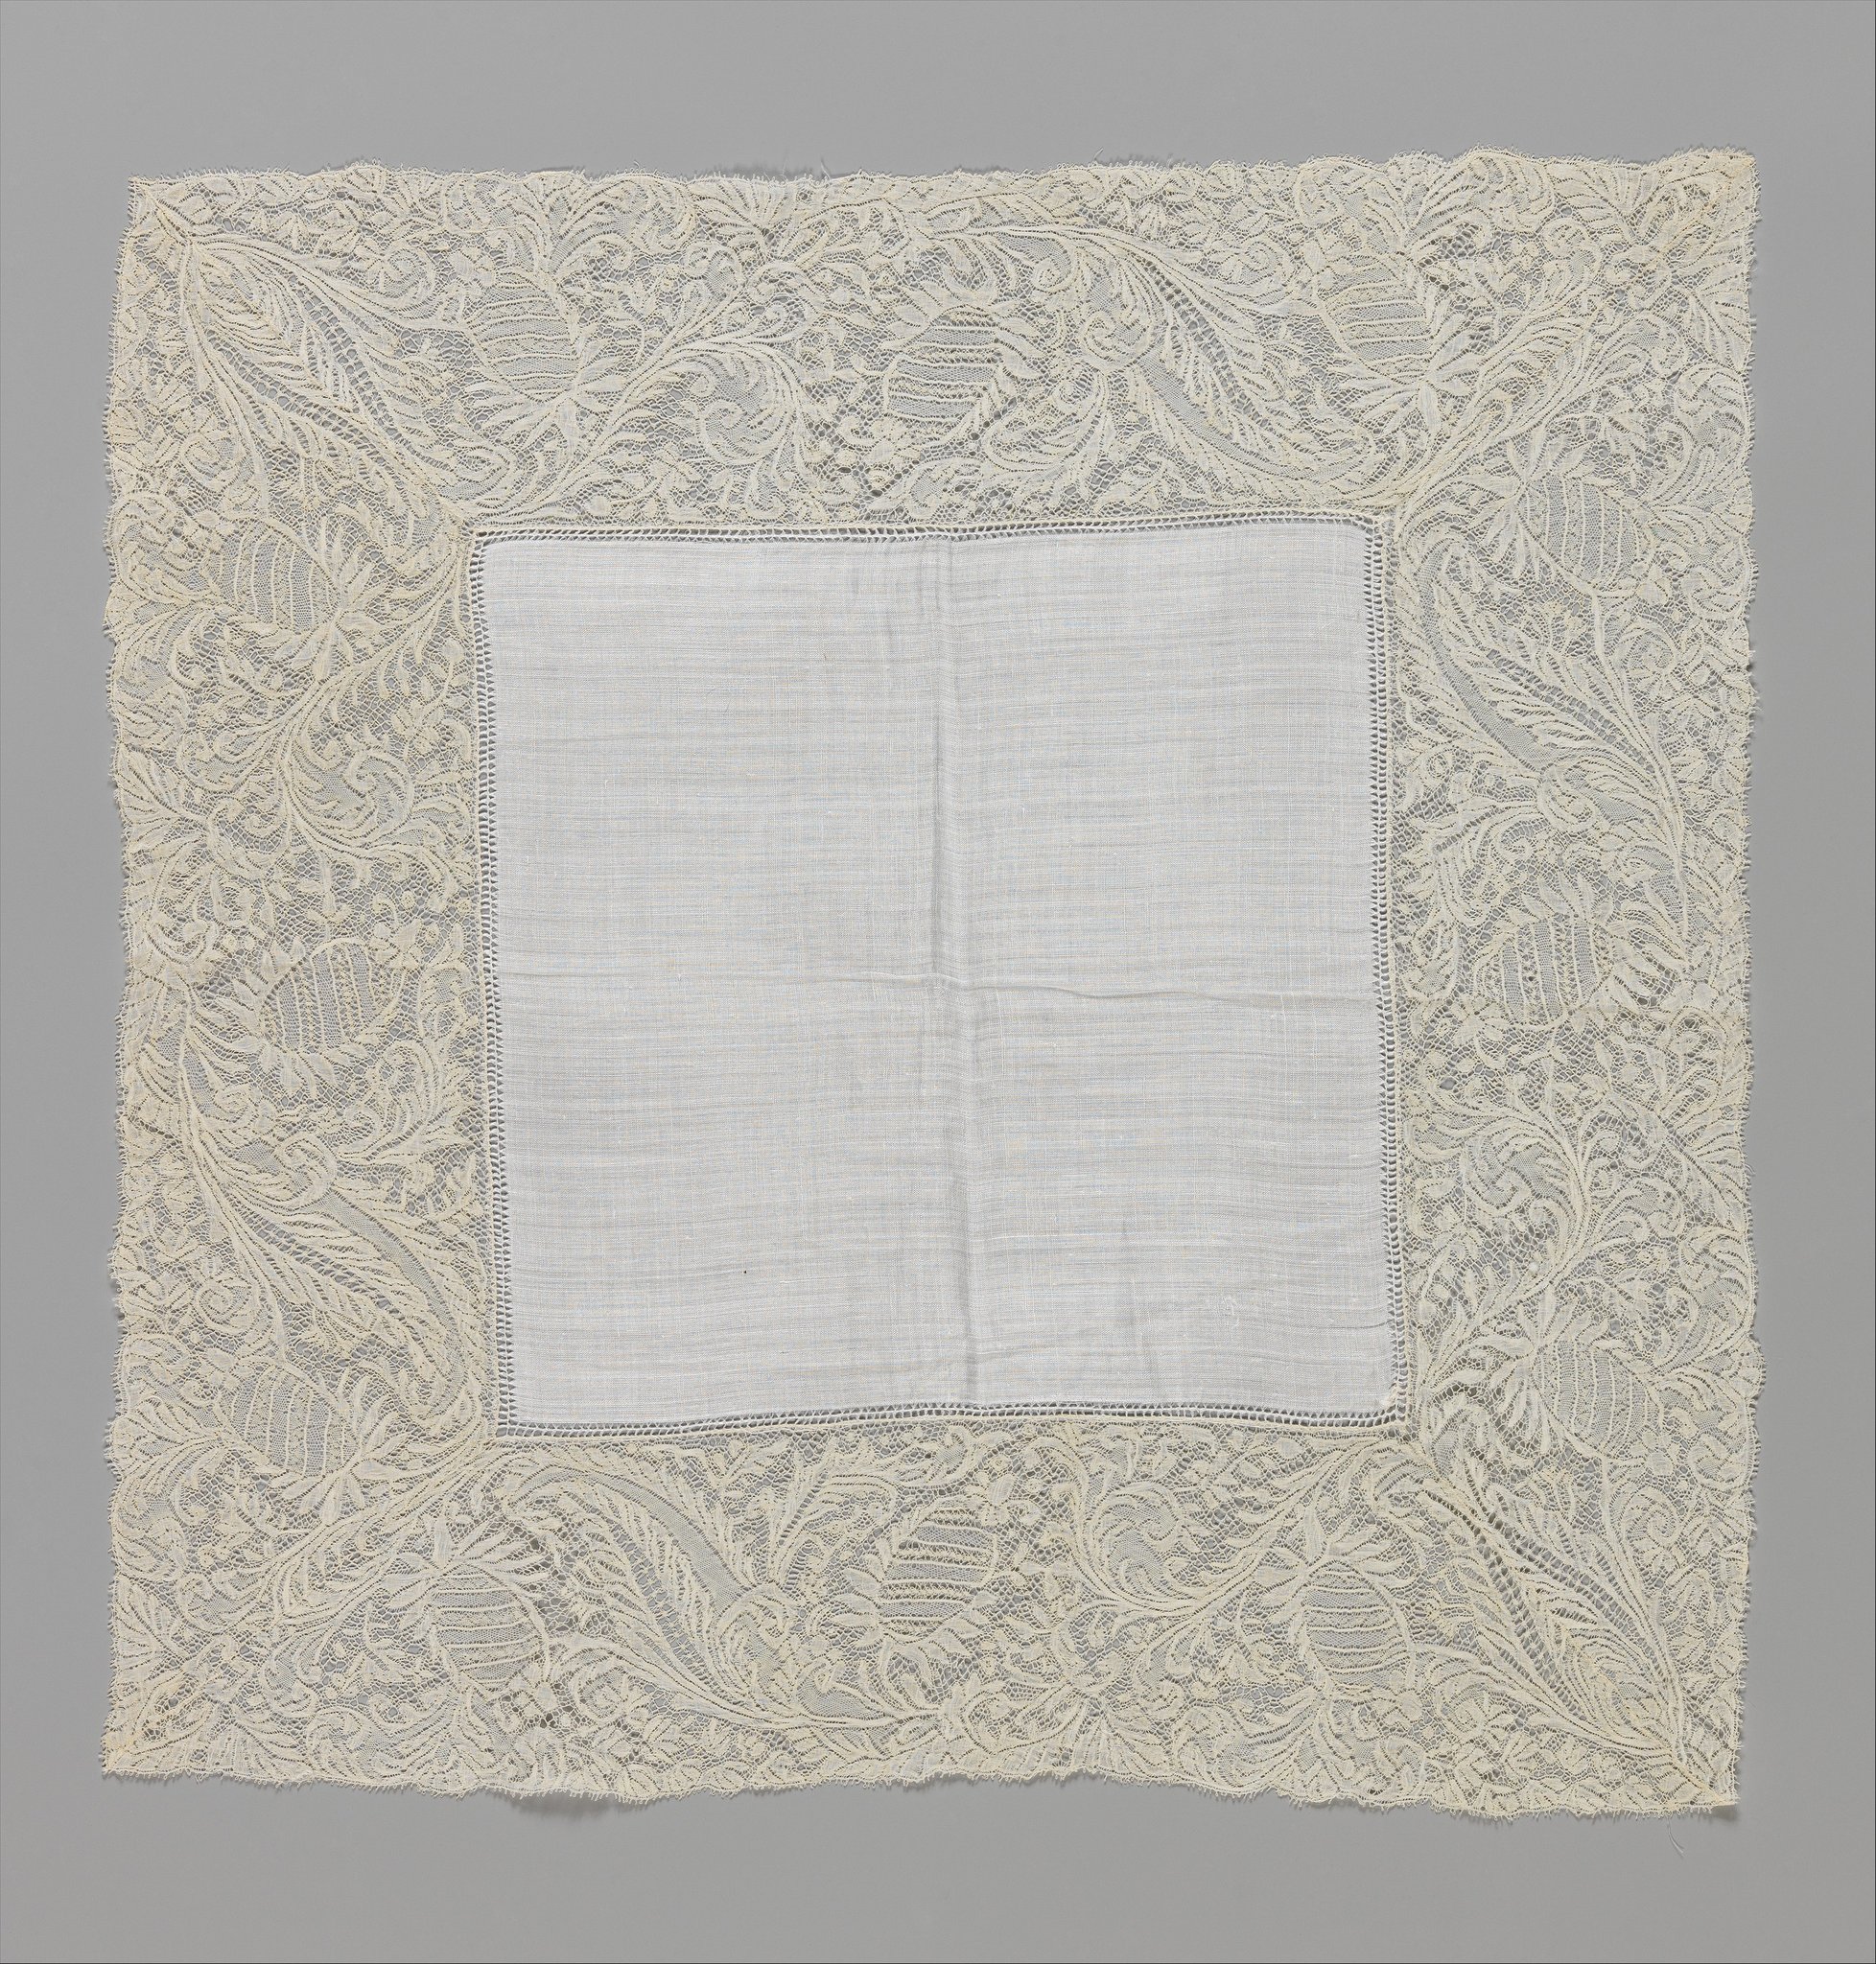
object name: handkerchief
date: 1867-1900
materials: lace, linen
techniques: lace, weave